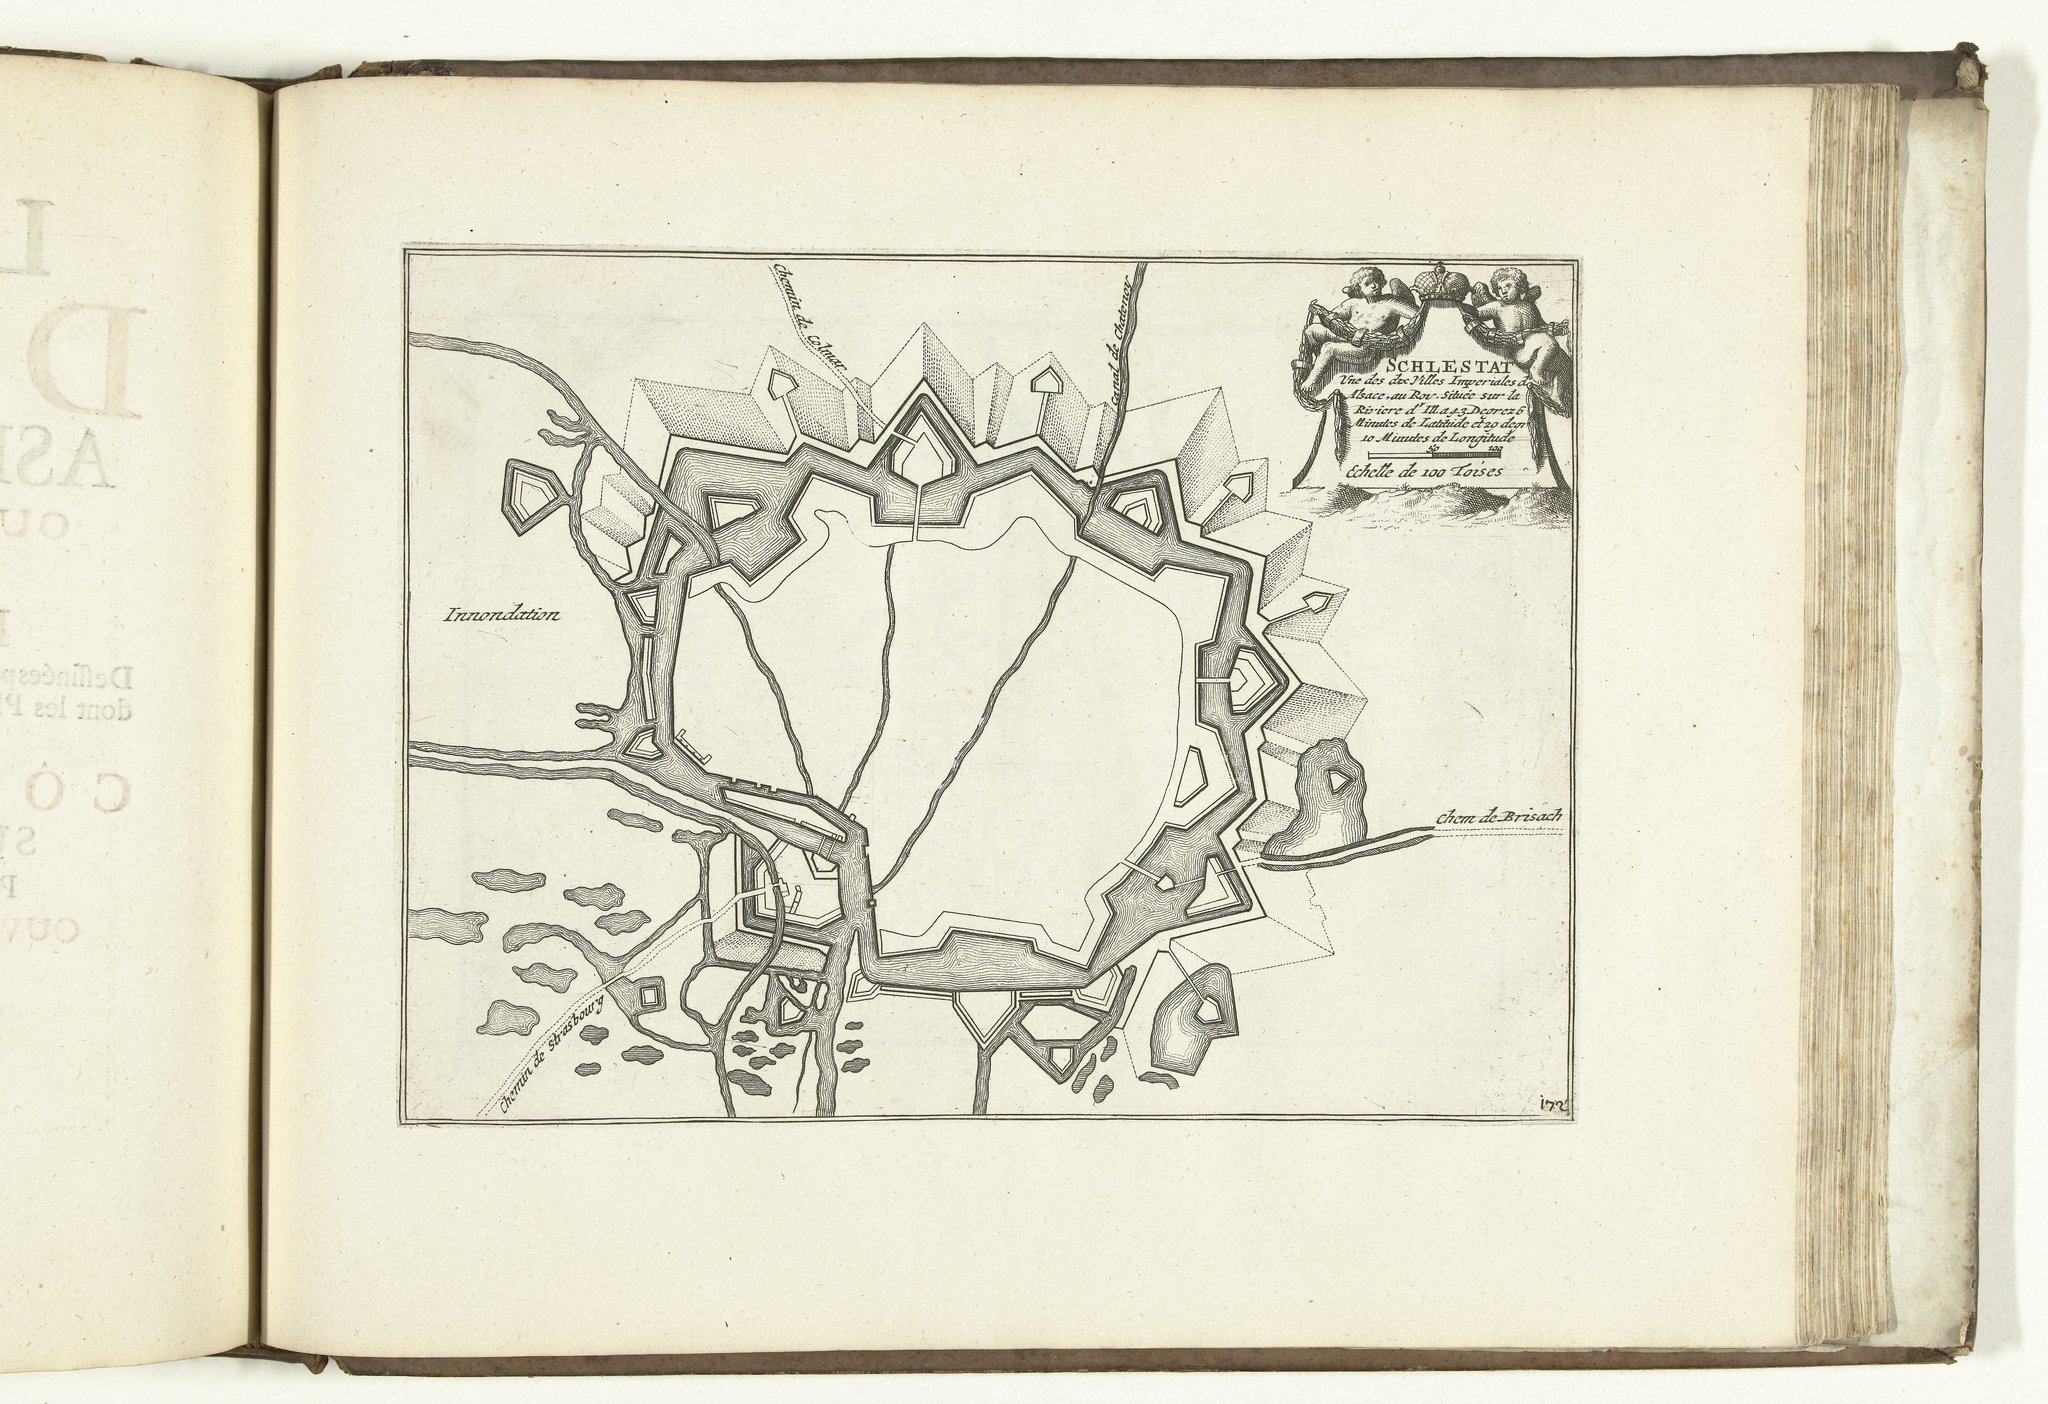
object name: map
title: Schlestat Une des dix Villes Imperiales d'Alsace (...)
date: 1726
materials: paper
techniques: etching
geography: leiden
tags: fortress, maps of cities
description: Plattegrond van de versterkingen om de stad Schlettstadt. Plaat nr. 172 in deel VIII van het prentwerk: Les Forces de l'Europe, Asie, Afrique et Amerique ... Comme aussi les Cartes des Côtes de France et d'Espagne uit 1726, dit eerste deel met 238 met de hand genummerde platen van vermaarde sterke steden en vestingen in het kader van de Spaanse Successieoorlog 1701-1713. Voor het merendeel zijn deze platen gekopieerd naar de anonieme Franse platen van vermaarde sterke steden en vestingen: in Les forces de l'Europe en in: Le theatre de la guerre, dans les Pays-Bas, beide oorspronkelijk uitgegeven door Nicolas de Fer te Parijs (1693-1697) in het kader van de Negenjarige Oorlog. Titel en opschriften in het Frans.